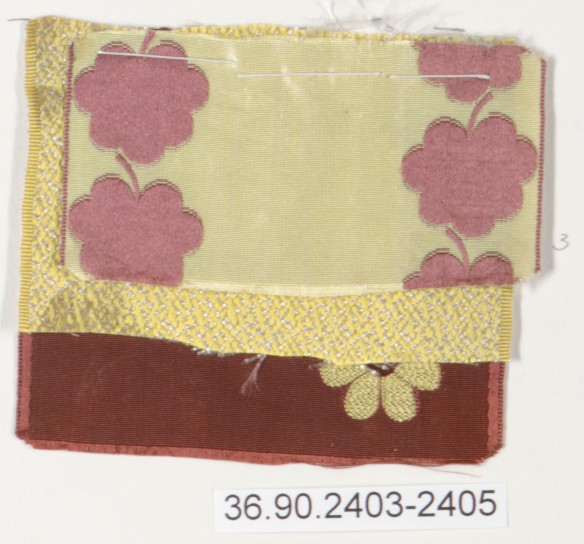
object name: ribbon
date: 1801-1900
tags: flowers